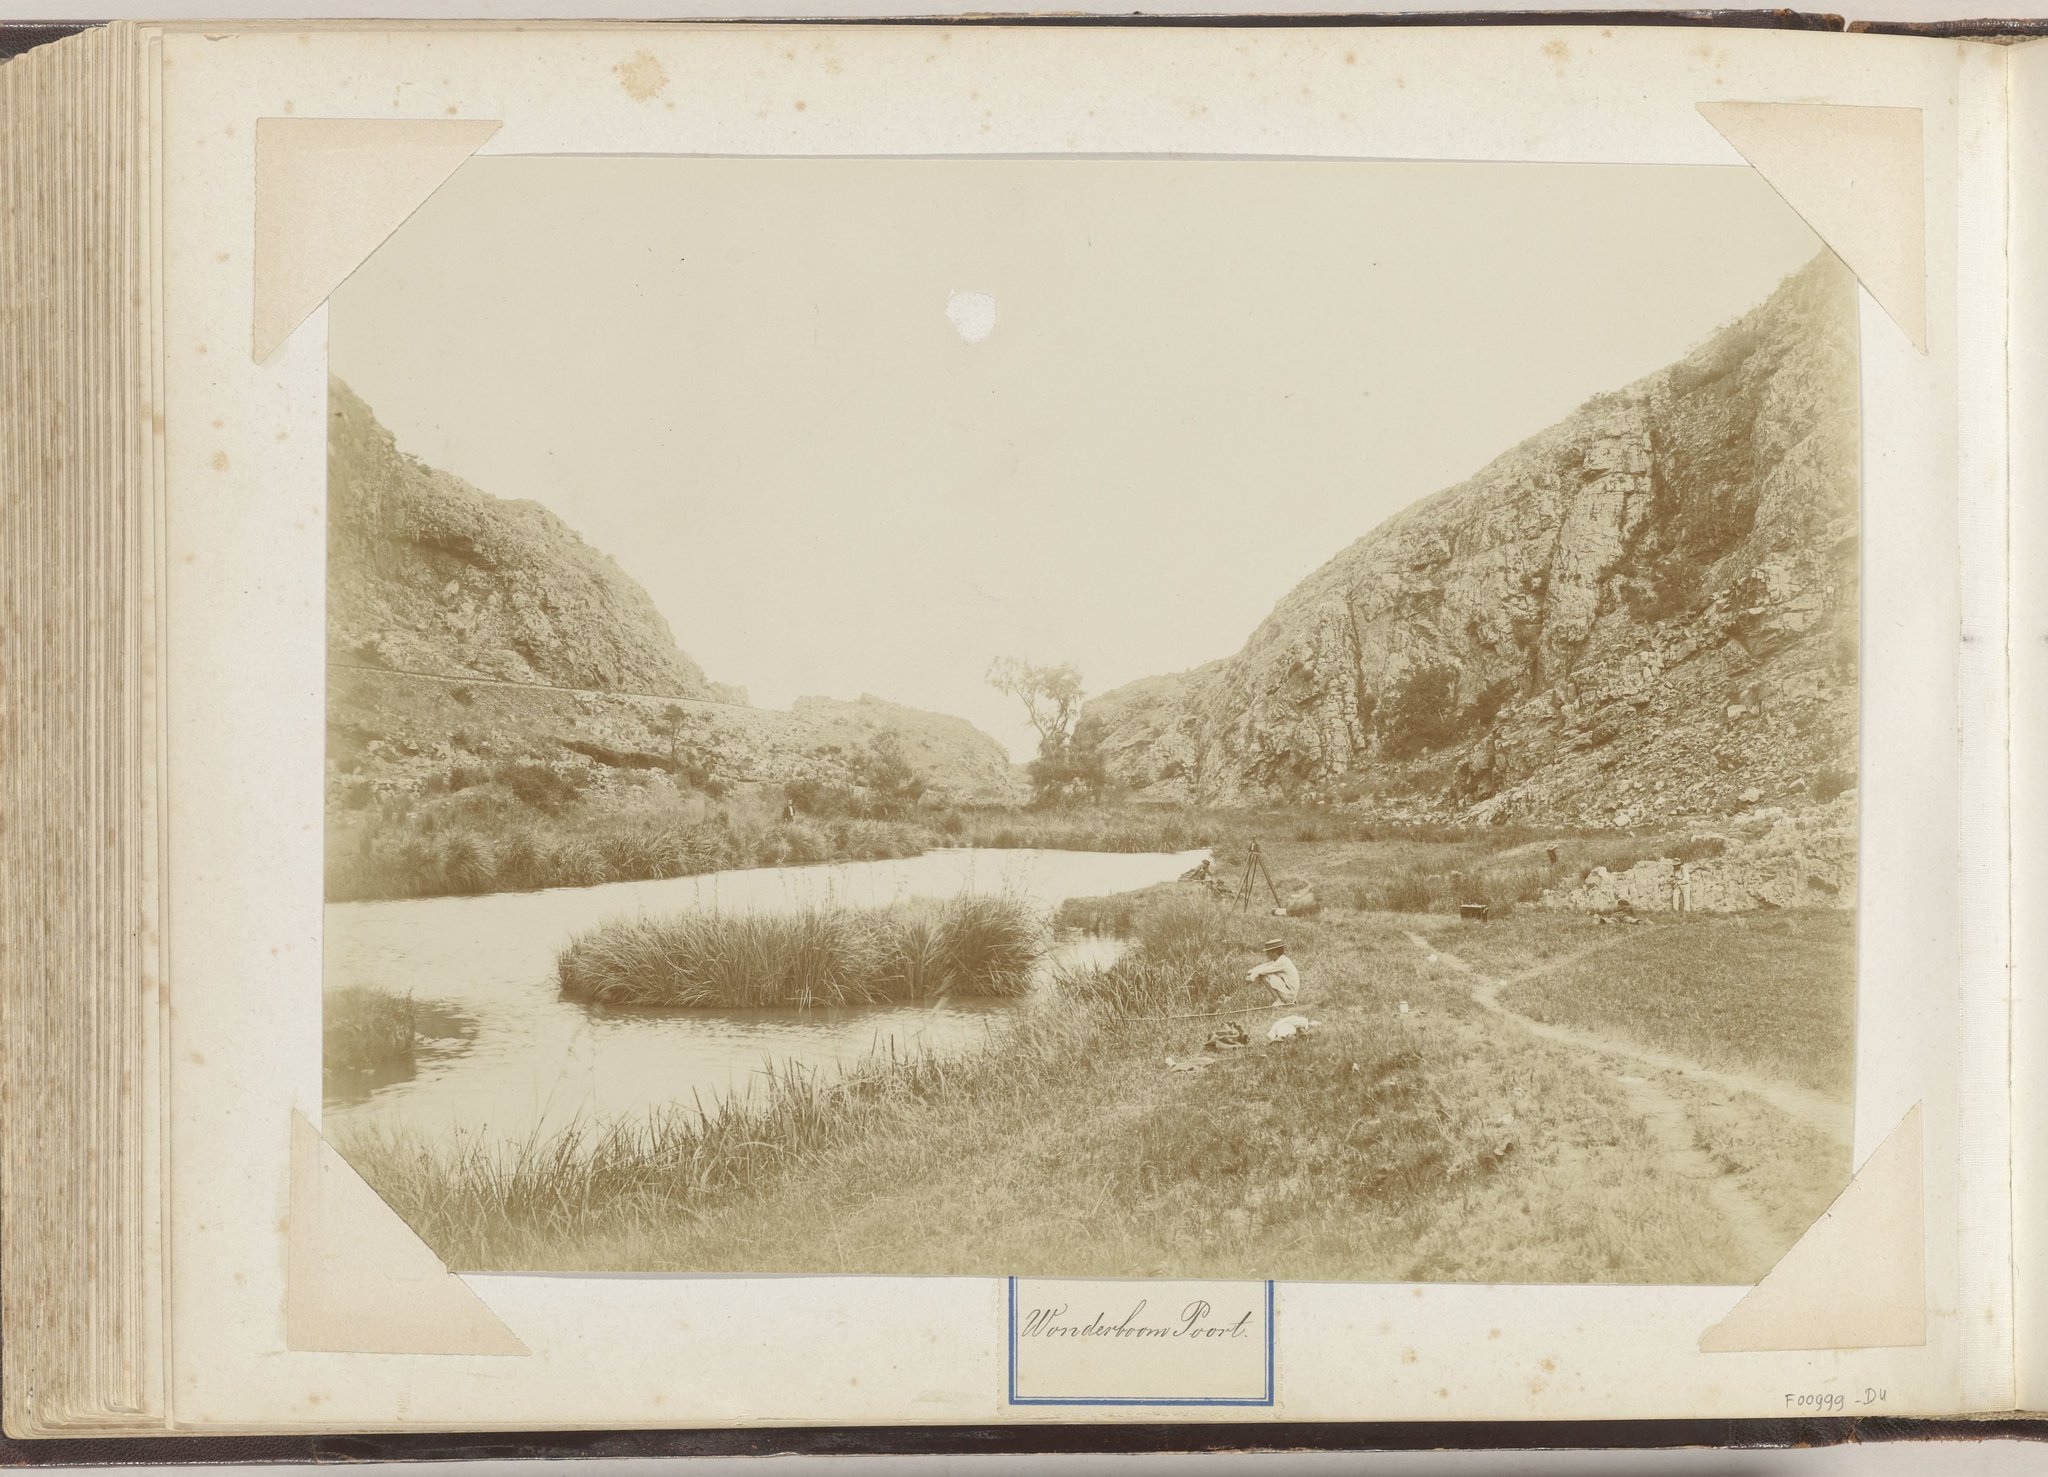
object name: photograph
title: Mannen met een statief bij kreek Wonderboom Poort in Zuid-Afrika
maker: Anonymous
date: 1890-1920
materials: paper, photographic support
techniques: gelatin silver print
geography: south africa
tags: tripod, landscapes with waters, waterscapes, seascapes (in the temperate zone)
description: Onderdeel van Album met 191 foto's van een reis naar en door Zuid-Afrika.